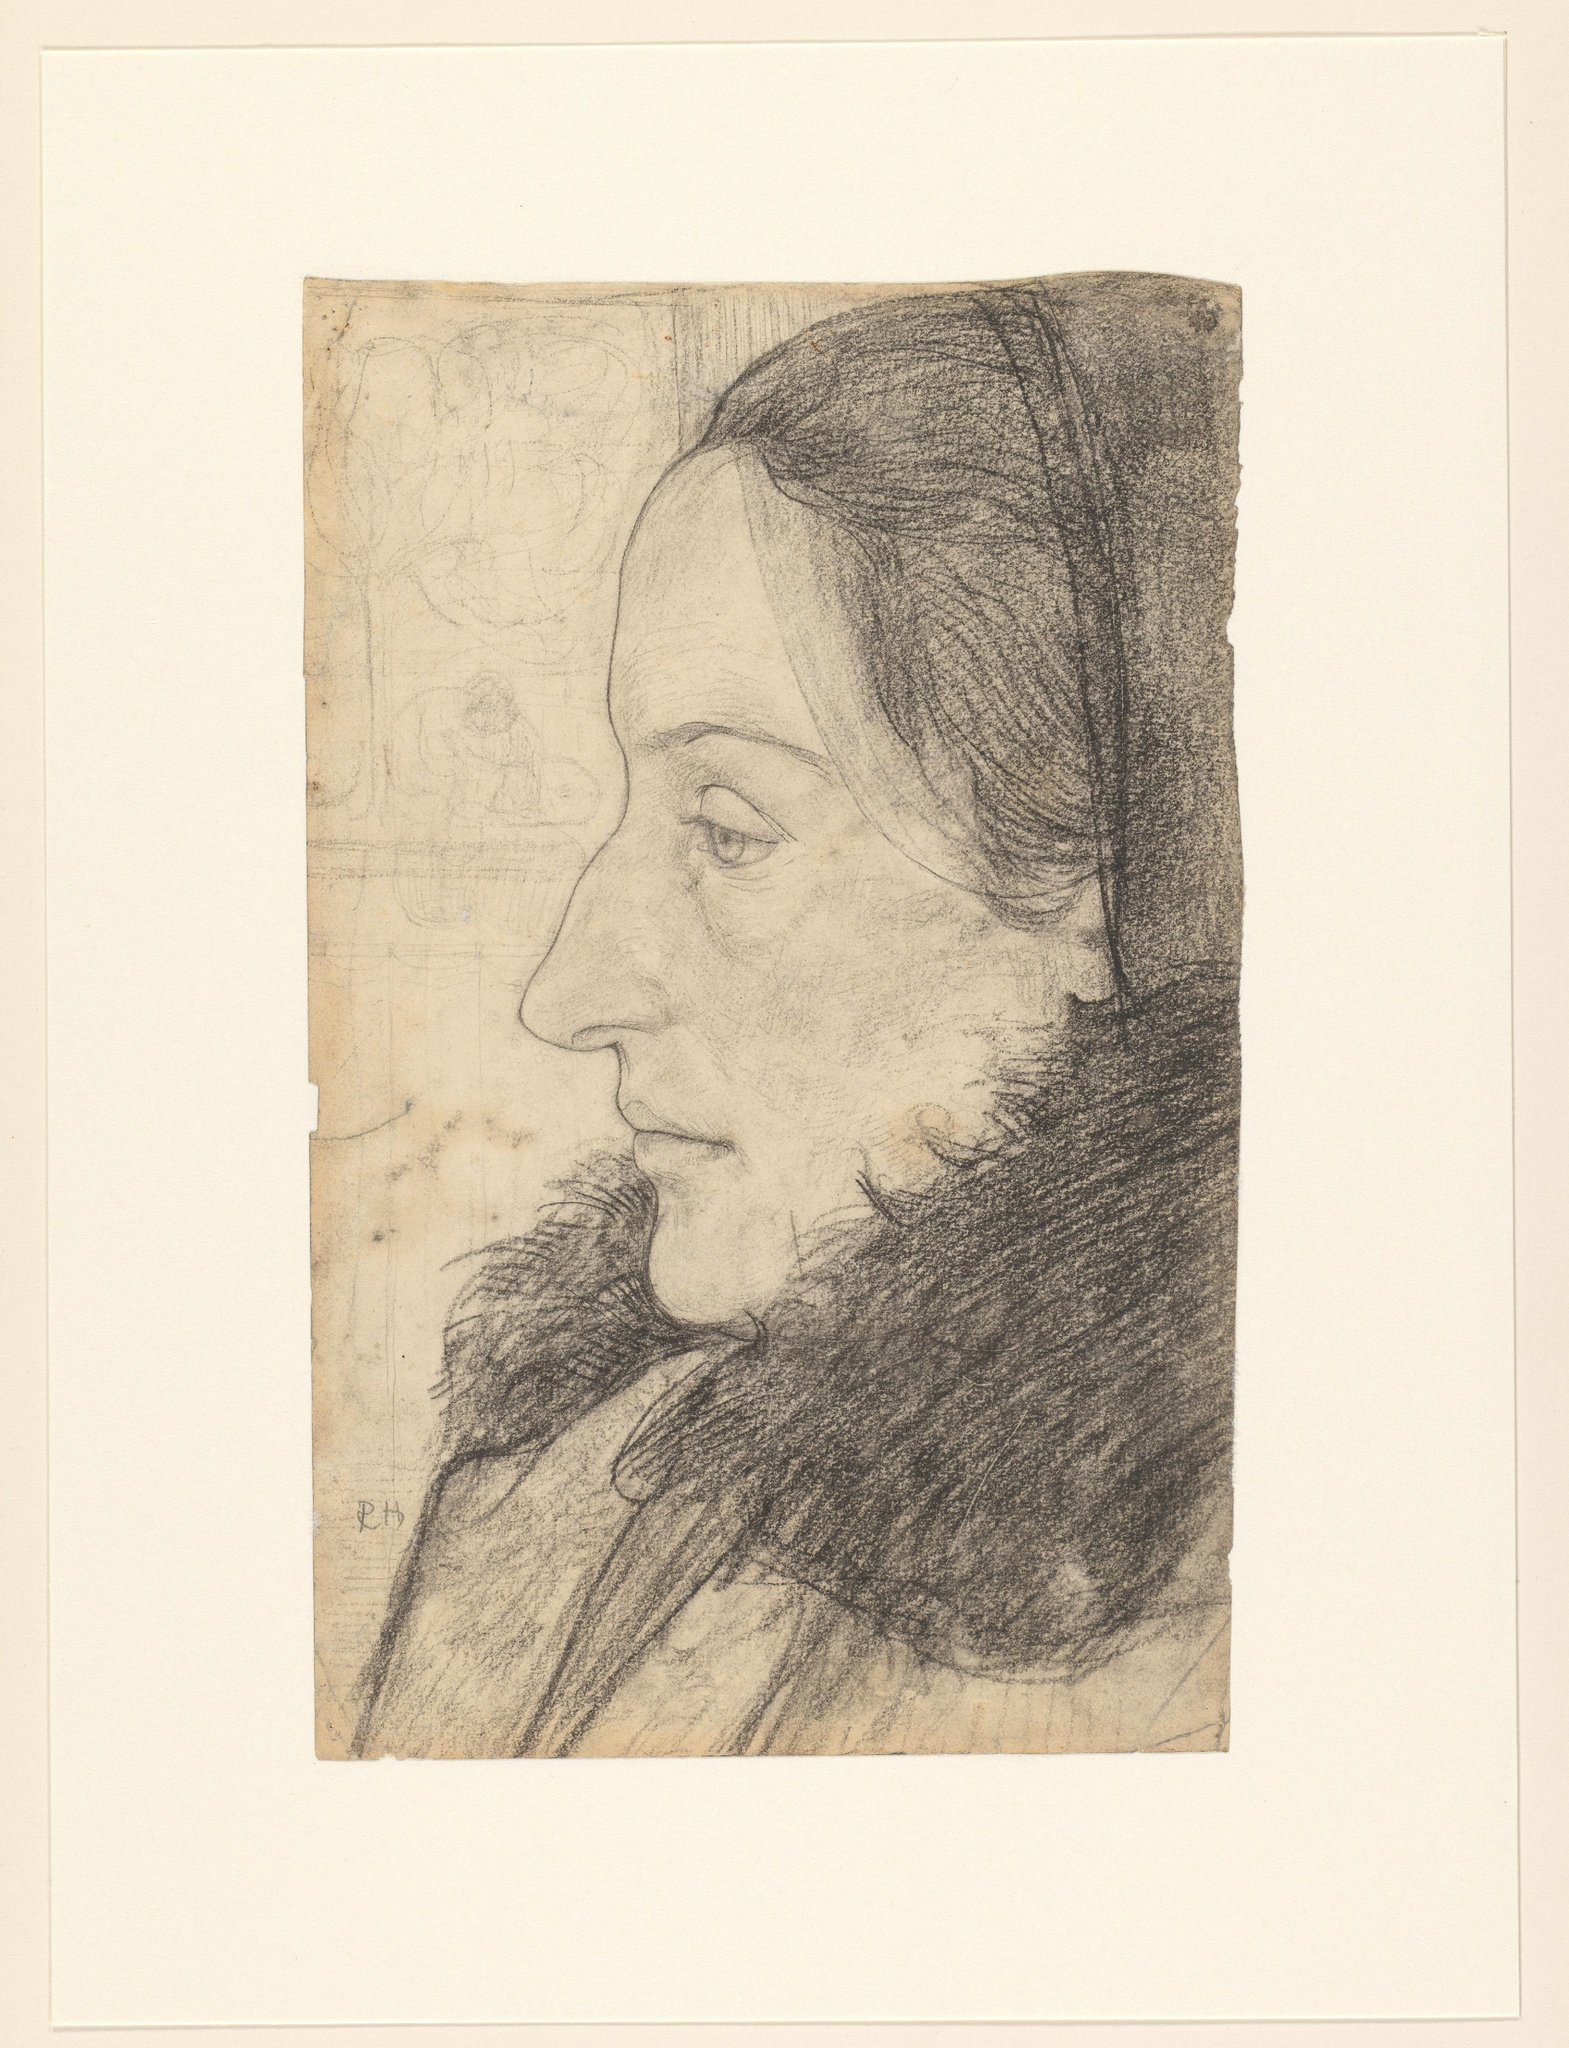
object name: drawing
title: Portret van een vrouw van opzij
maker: richard nicolaüs roland holst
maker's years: 1868-1938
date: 1878-1938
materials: chalk, paper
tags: anonymous historical person portrayed alone